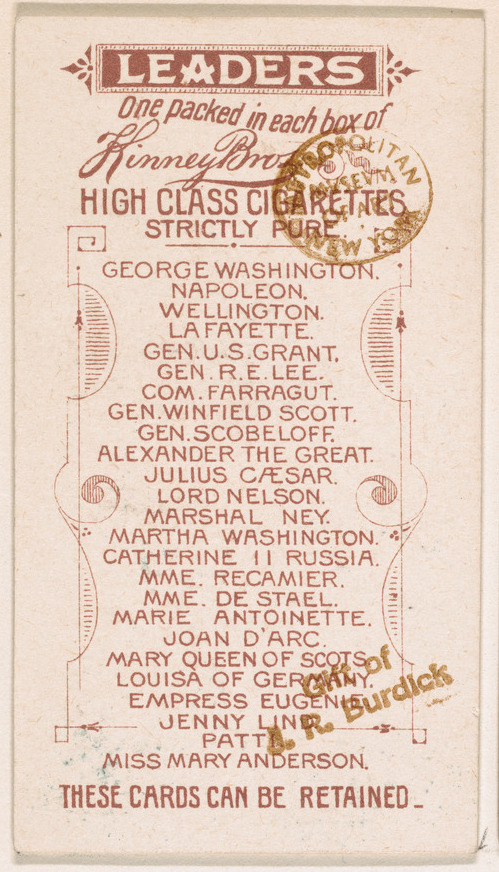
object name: print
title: Example of card verso from Leaders series (N222) issued by Kinney Bros.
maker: kinney brothers tobacco company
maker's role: publisher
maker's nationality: american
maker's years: 1869-2011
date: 1888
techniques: color lithograph